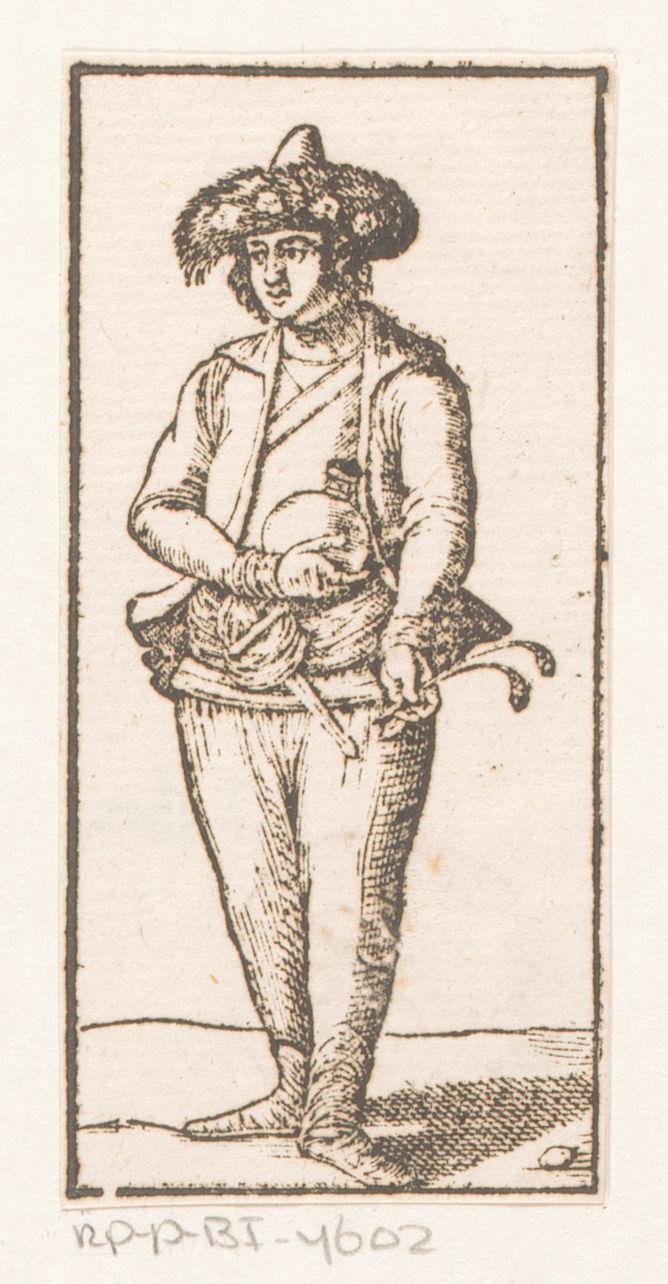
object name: print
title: Staande man met een hoed en een kruik in zijn hand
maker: Anonymous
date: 1600-1699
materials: paper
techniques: woodcut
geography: netherlands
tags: head-gear, adult man (+ standing), container of ceramics: jar, jug, pot, vase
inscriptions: collector's mark: Lugt 240